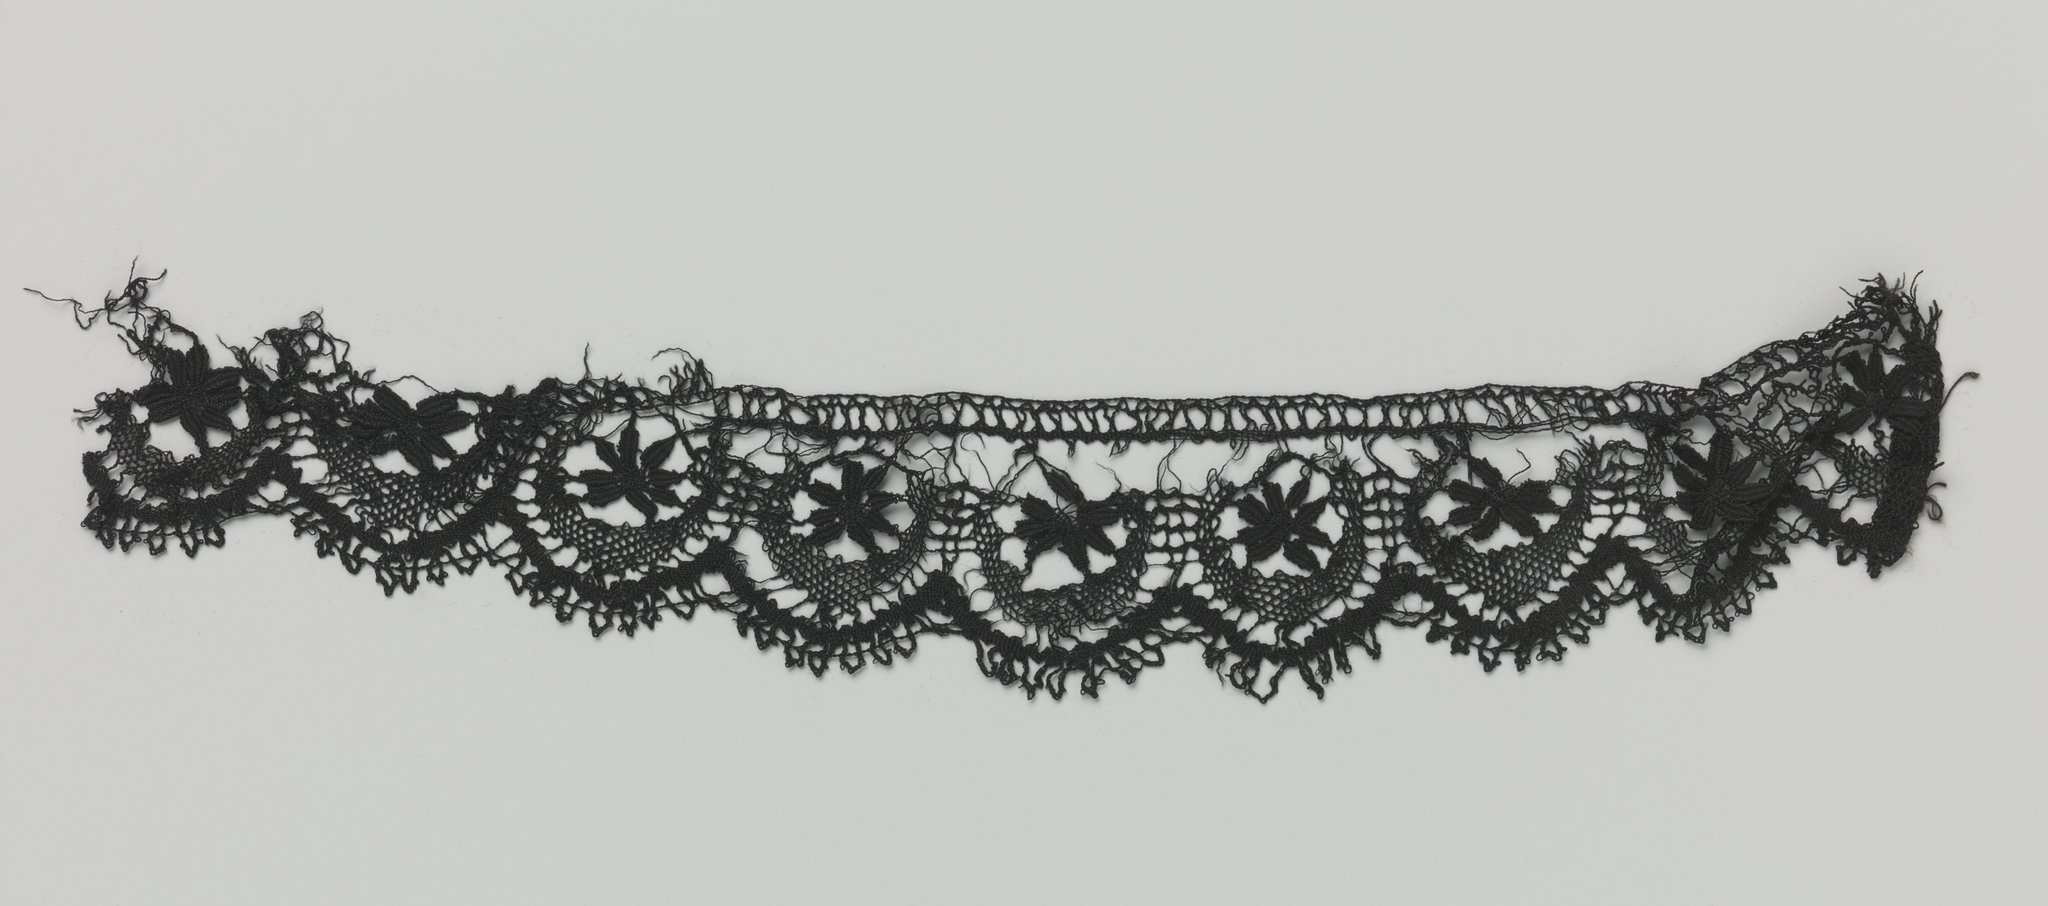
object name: strip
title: Strook kloskant met ster en halve maan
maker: Anonymous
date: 1900-1929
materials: silk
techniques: lace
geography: le puy-en-velay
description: Strook zwarte kloskant, Cluny-kant. Symmetrisch dessin met diepe schulpen en een vlechtengrond. Elke schulp is gevuld met een achtpuntige ster die aan de onderzijde wordt omvat door een liggende halve maan. De schulpenrand is afgewerkt met boogjes en fijne puntjes van gepicoteerde vlechtjes. De bovenzijde van de strook is recht afgewerkt.